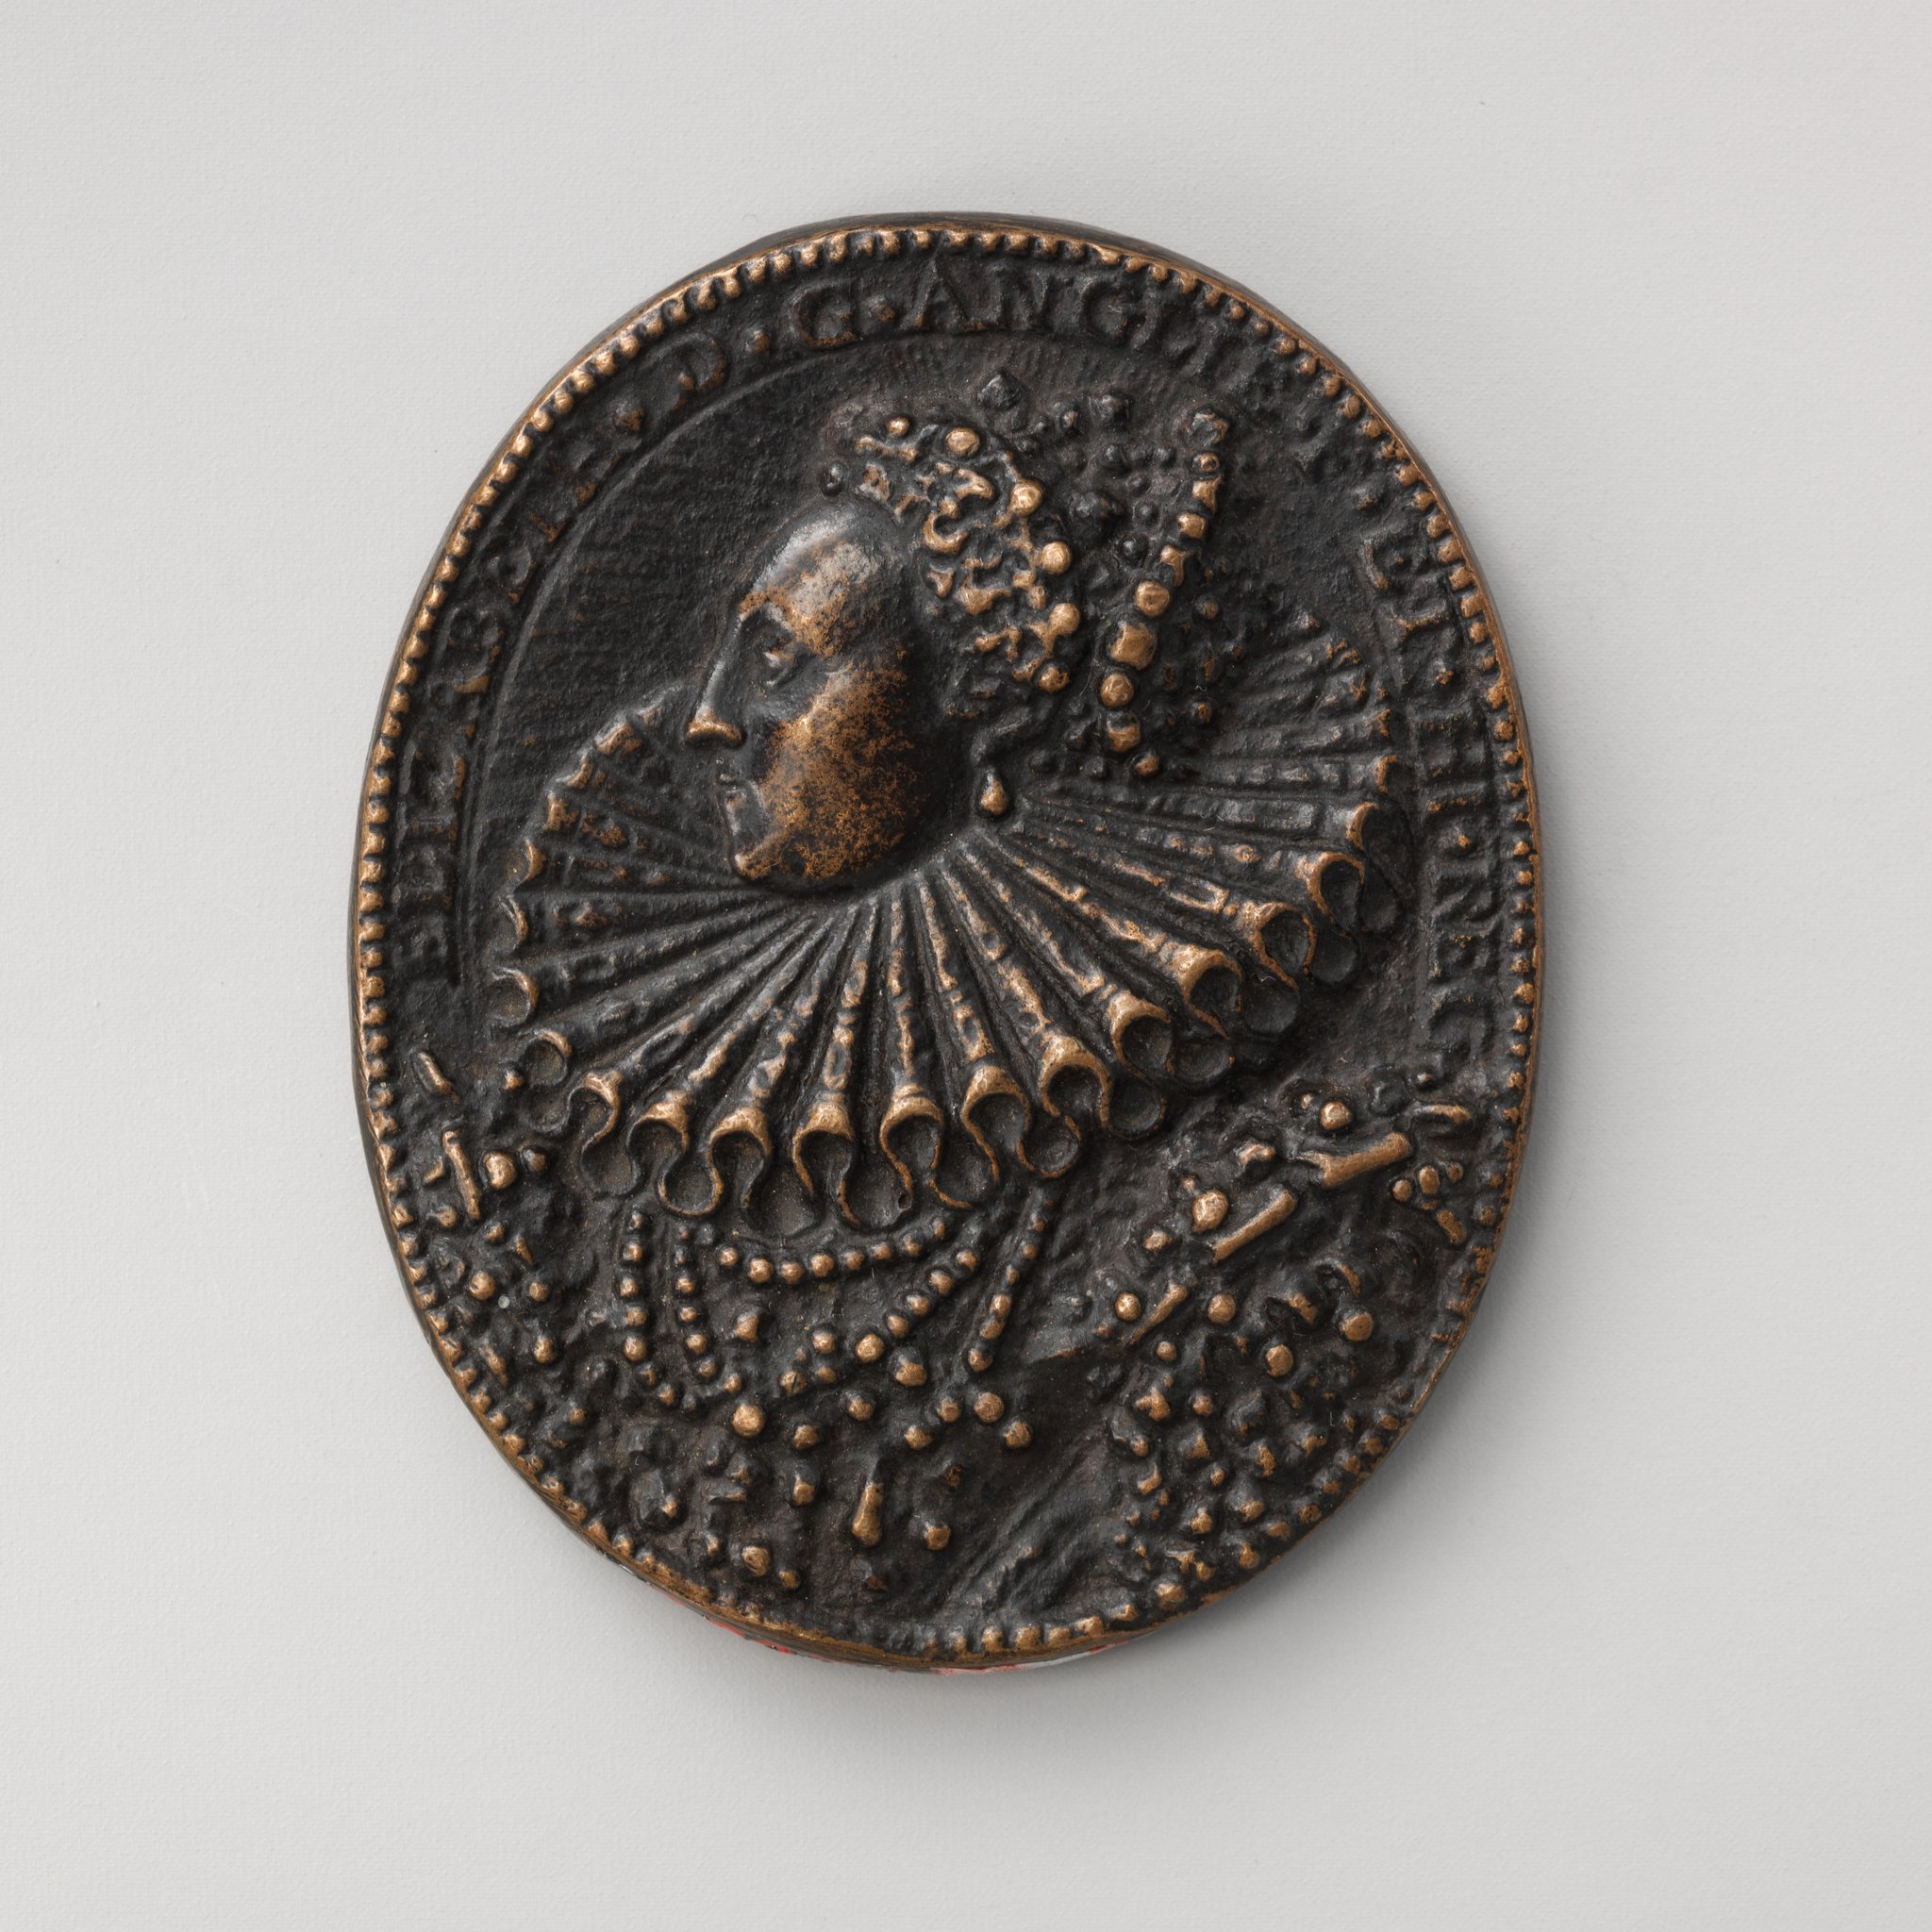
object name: medal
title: Naval Reward Medal of Elizabeth I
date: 1701-1800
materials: bronze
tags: elizabeth i,profiles